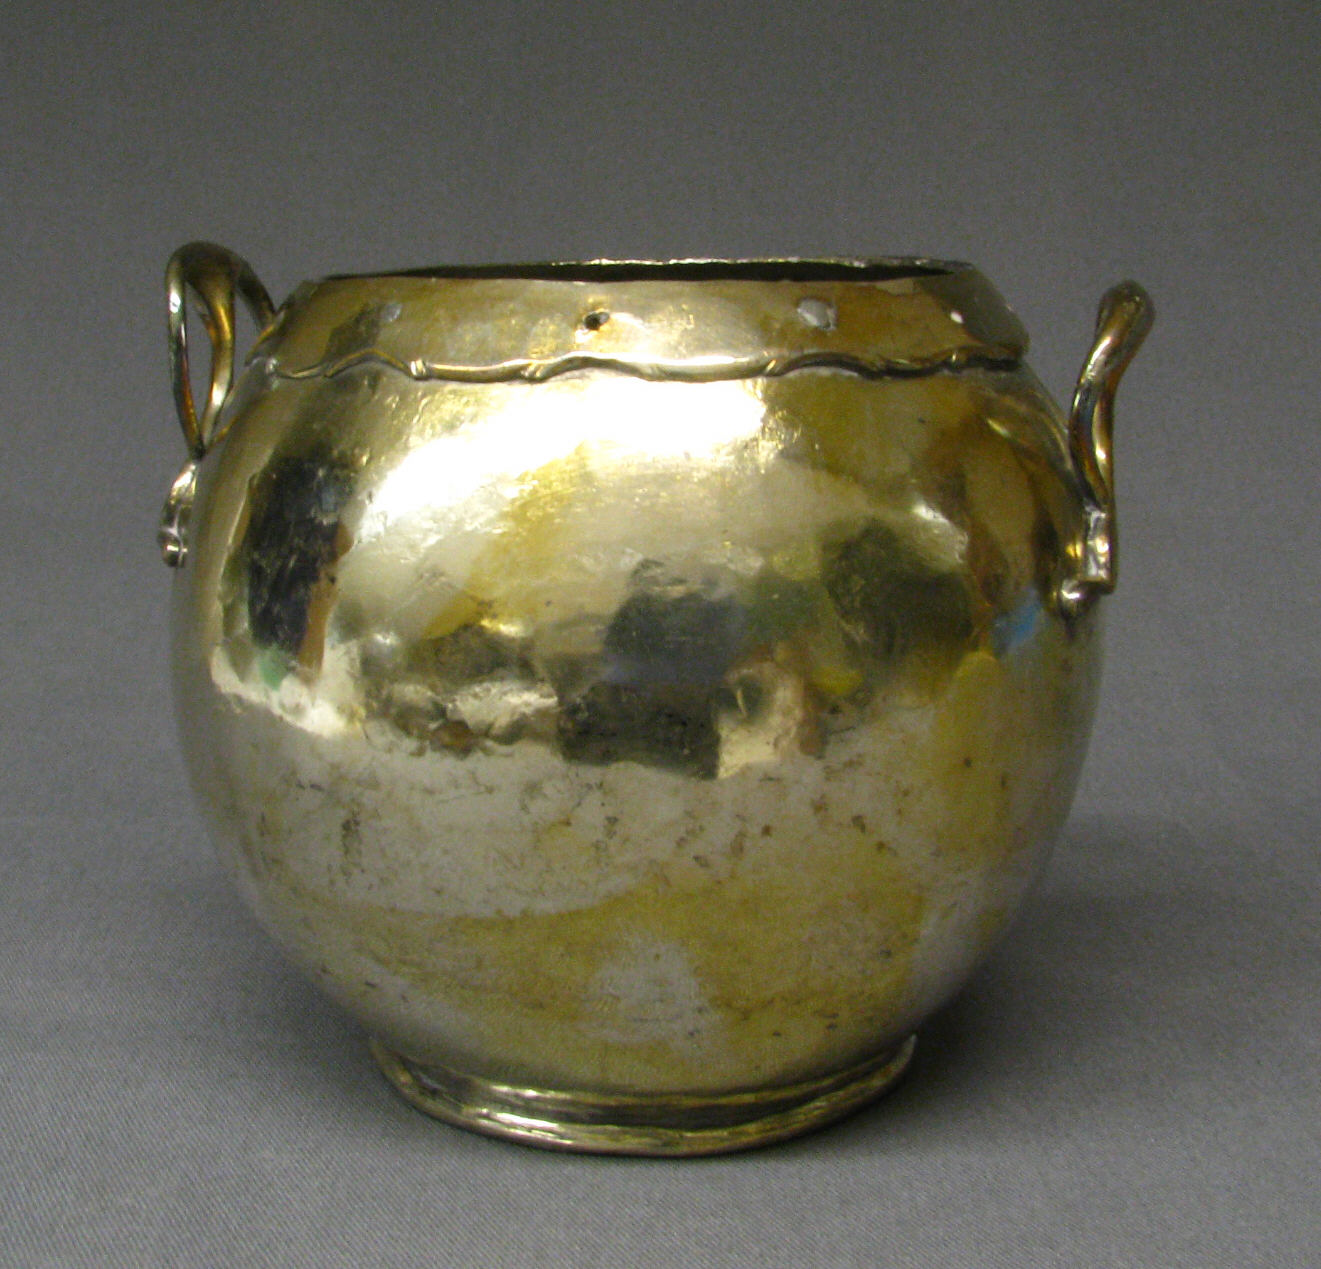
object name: pot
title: Two-handled pot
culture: south american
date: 1701-1800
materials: silver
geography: peru